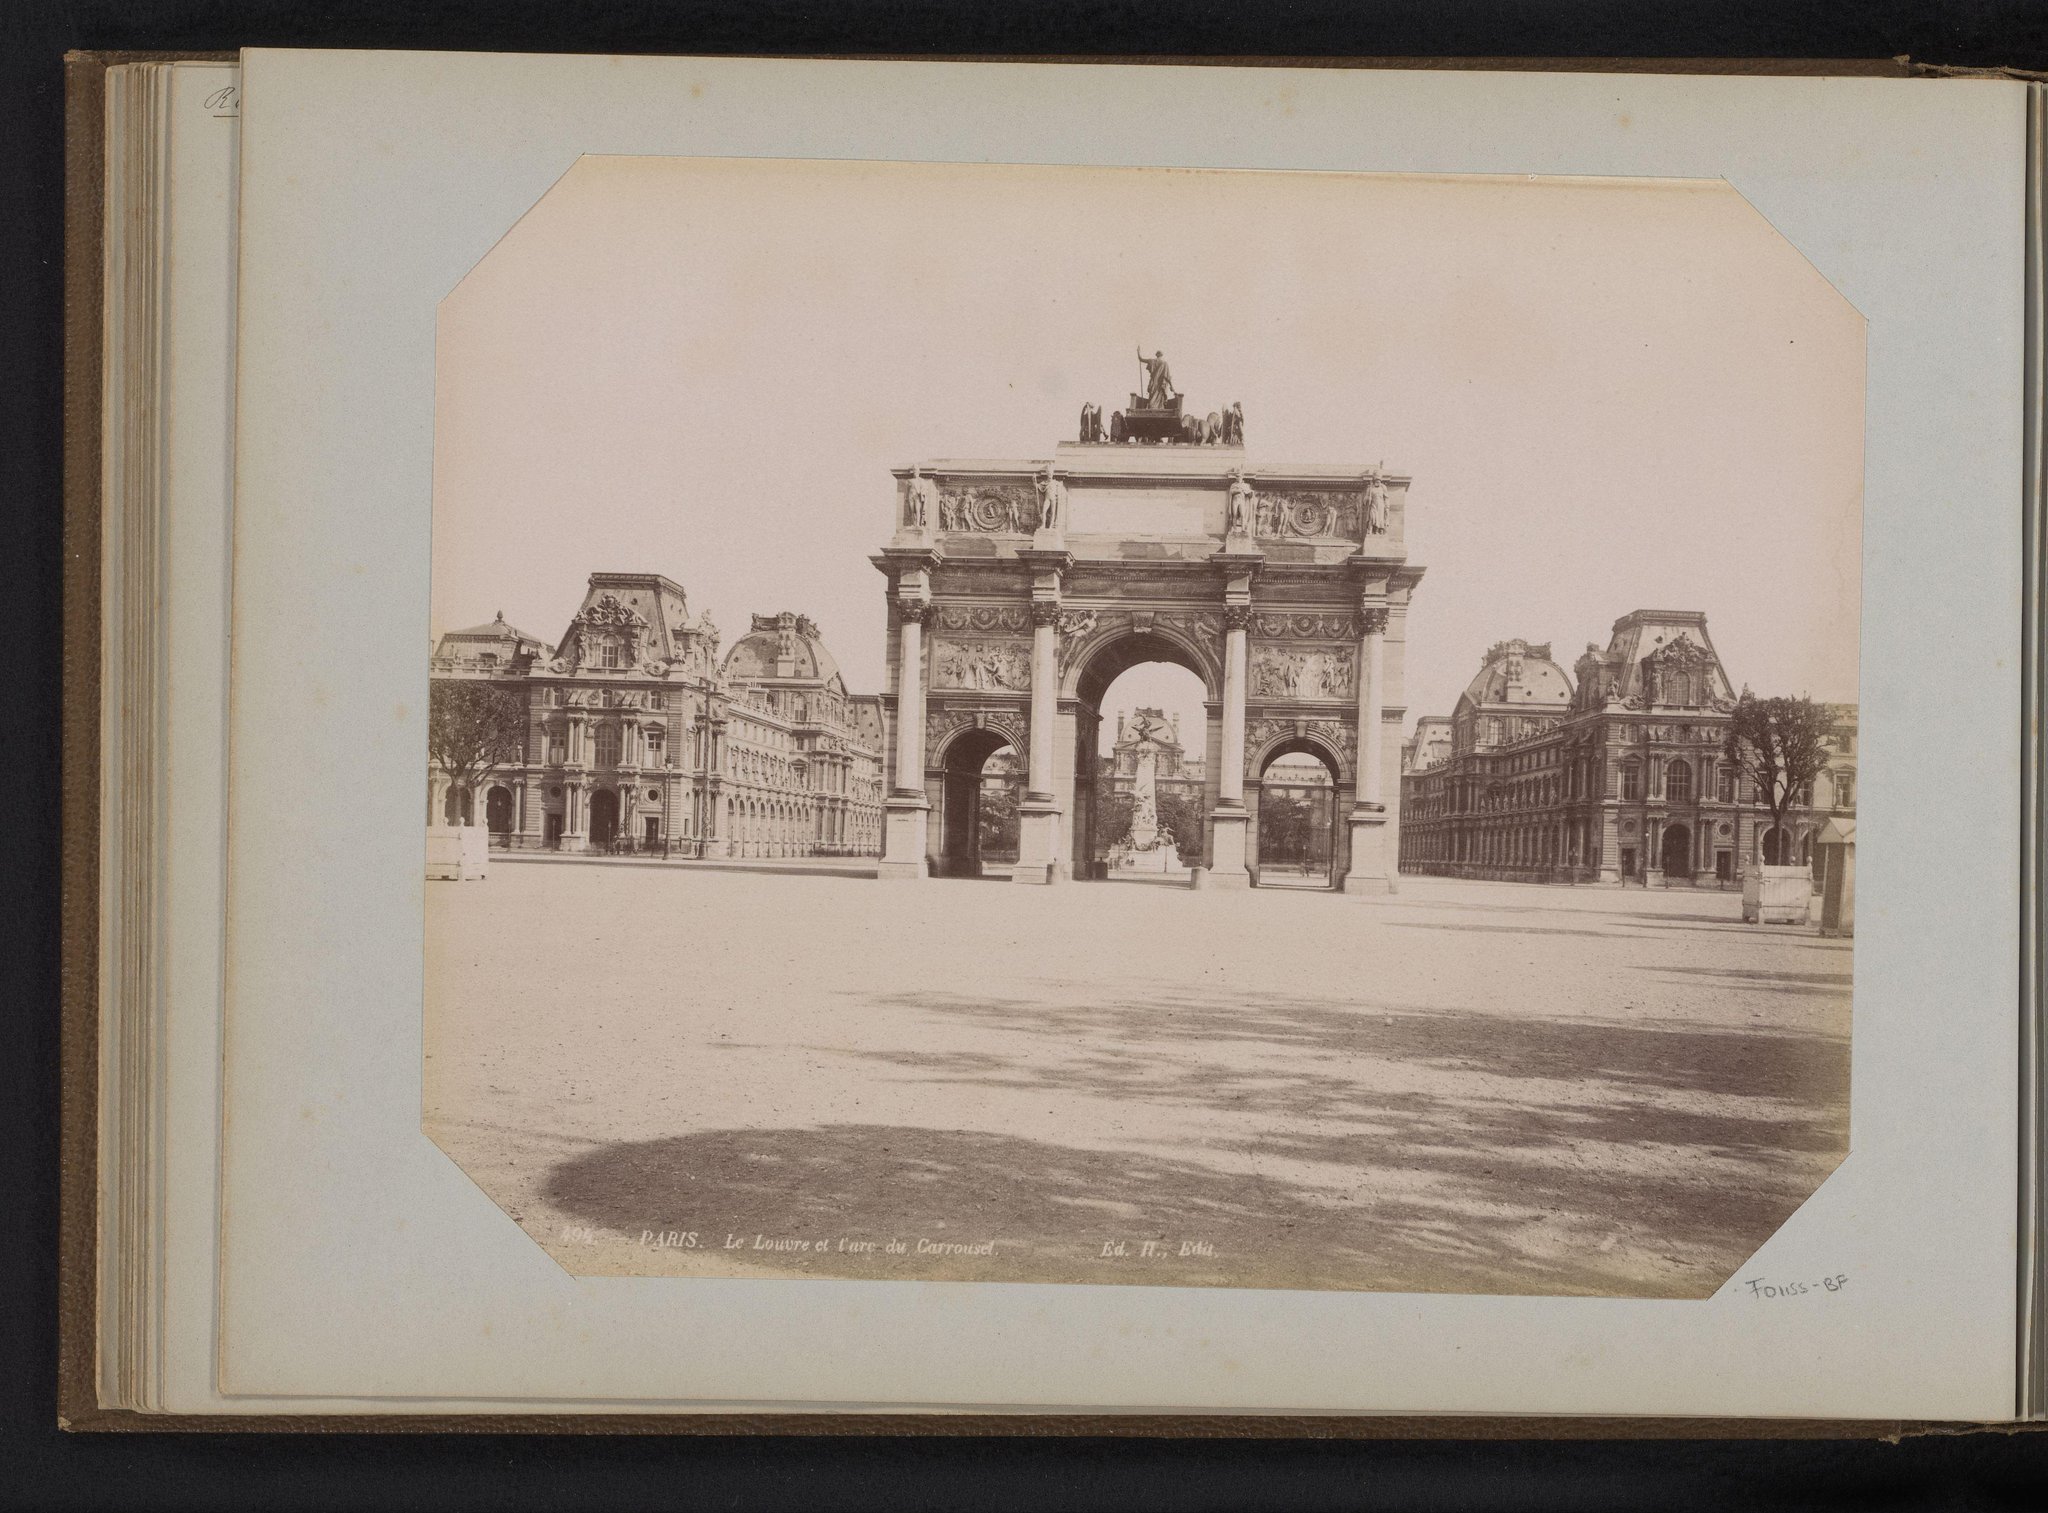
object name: photograph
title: Gezicht op de Arc de Triomphe du Carrousel met het Louvre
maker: edouard hautecoer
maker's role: publisher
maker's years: 1847-1904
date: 1890-1898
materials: photographic support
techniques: albumen print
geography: paris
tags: triumphal arch, permanent exhibition, museum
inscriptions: inscription: ‘494. - Paris. Le Louvre et l'arc du Carrousel. Ed. H., édit’, retailer's mark: ‘E. Hautecoeur/ Estampes Photographies/ 35 Avenue de l'Opéra, 35/ Paris’